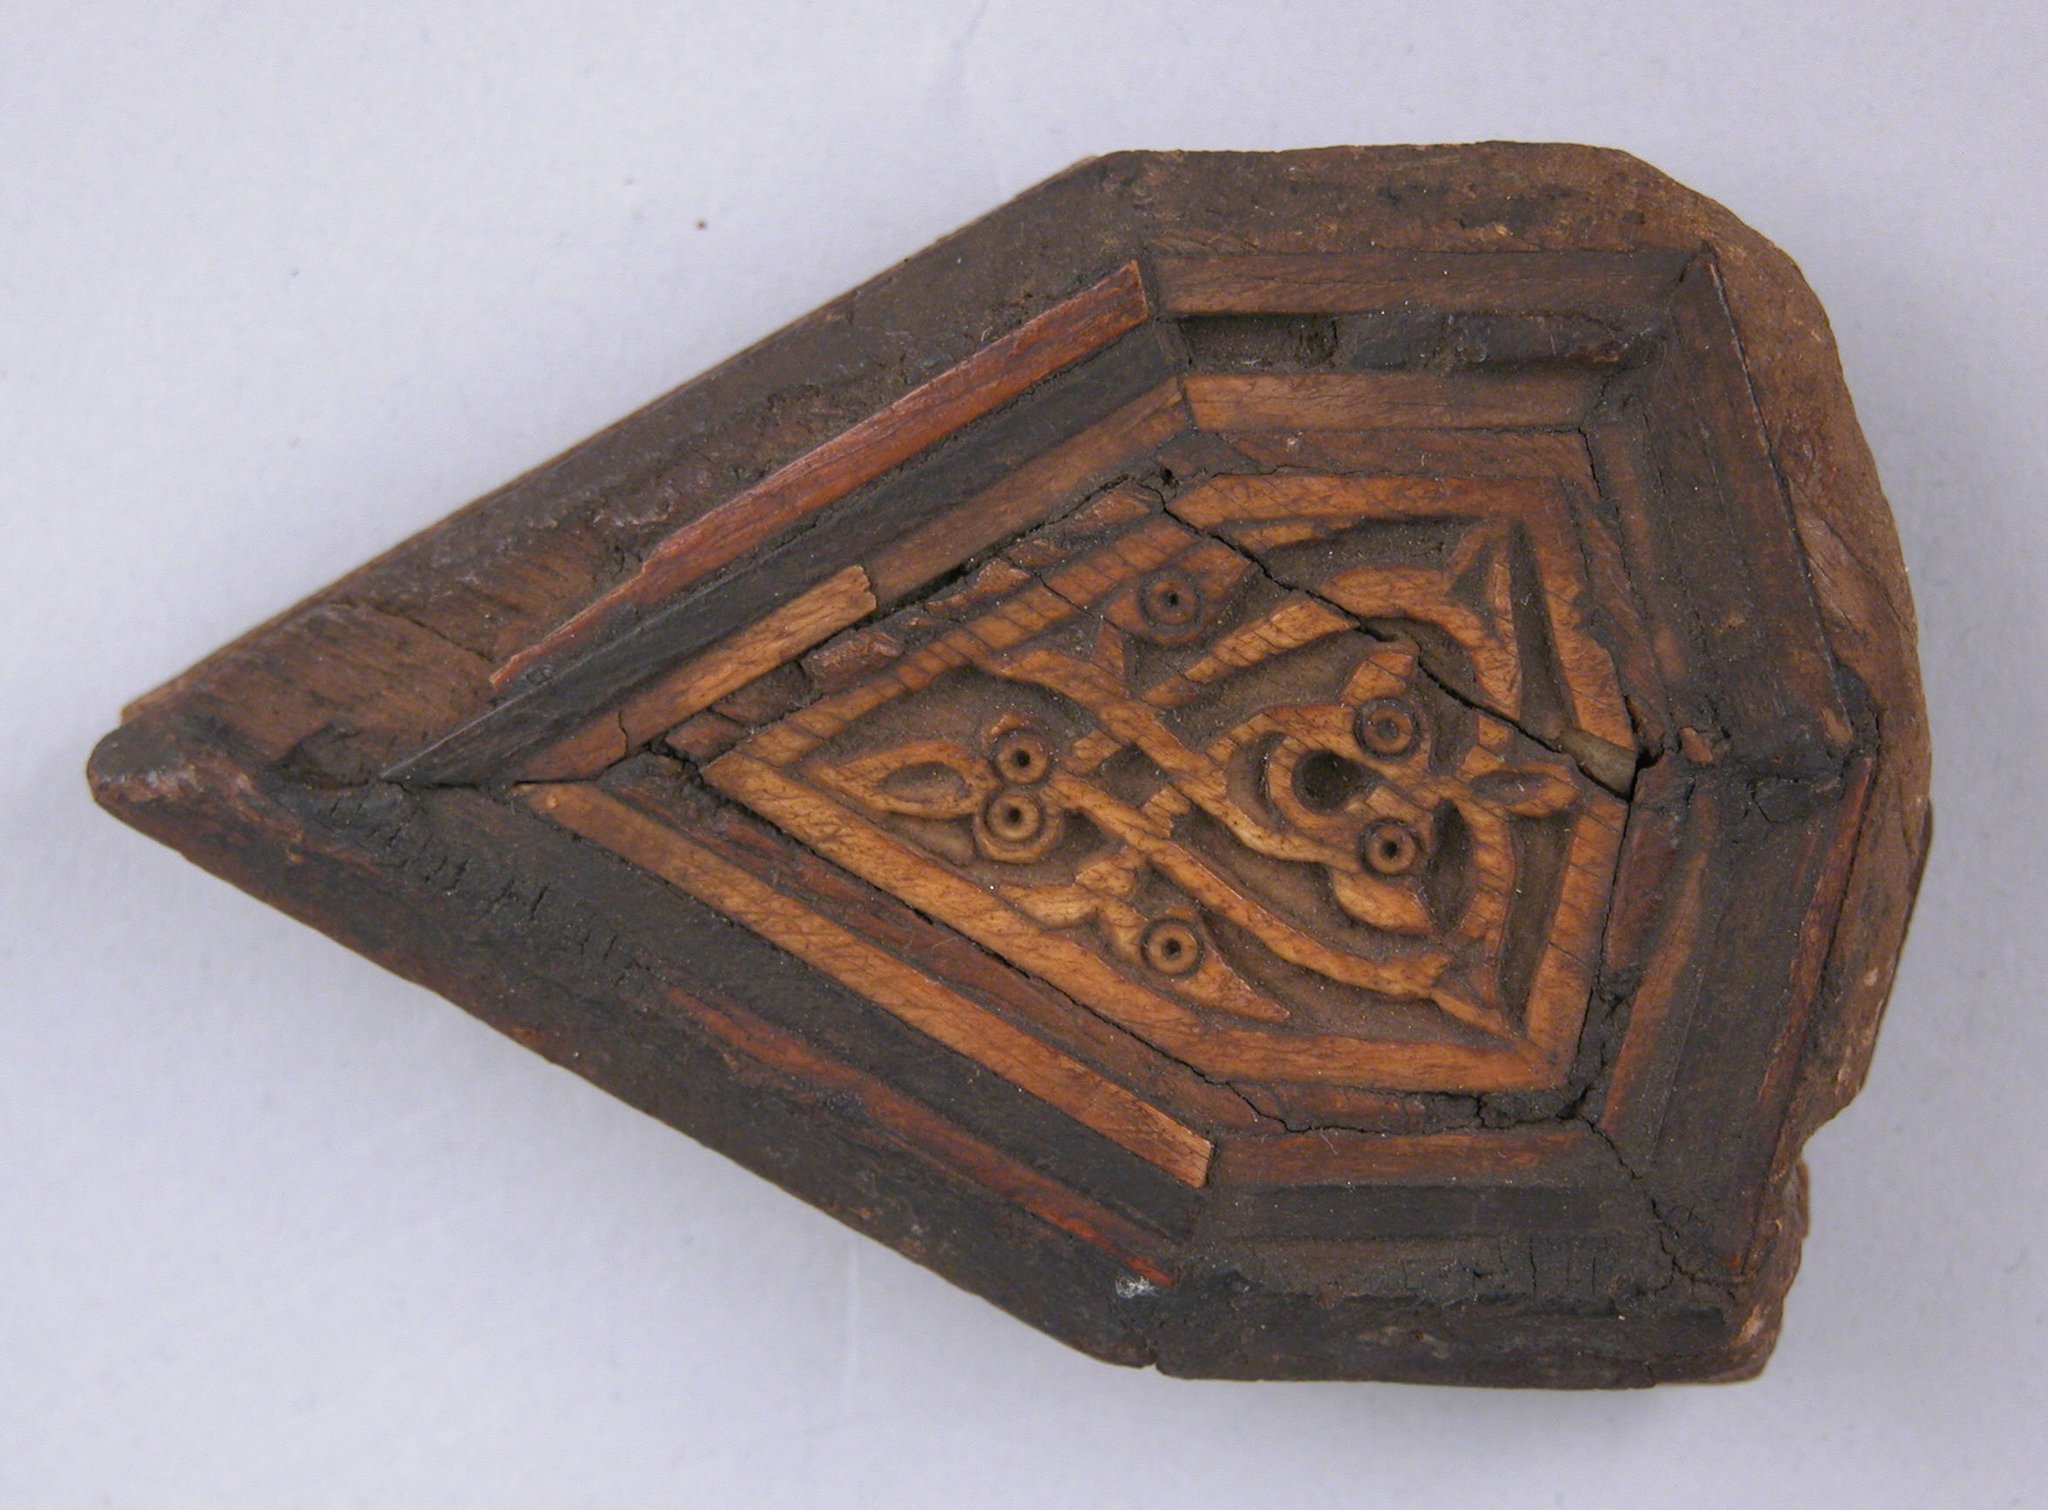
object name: panel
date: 1301-1500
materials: ivory, wood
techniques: inlay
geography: egypt